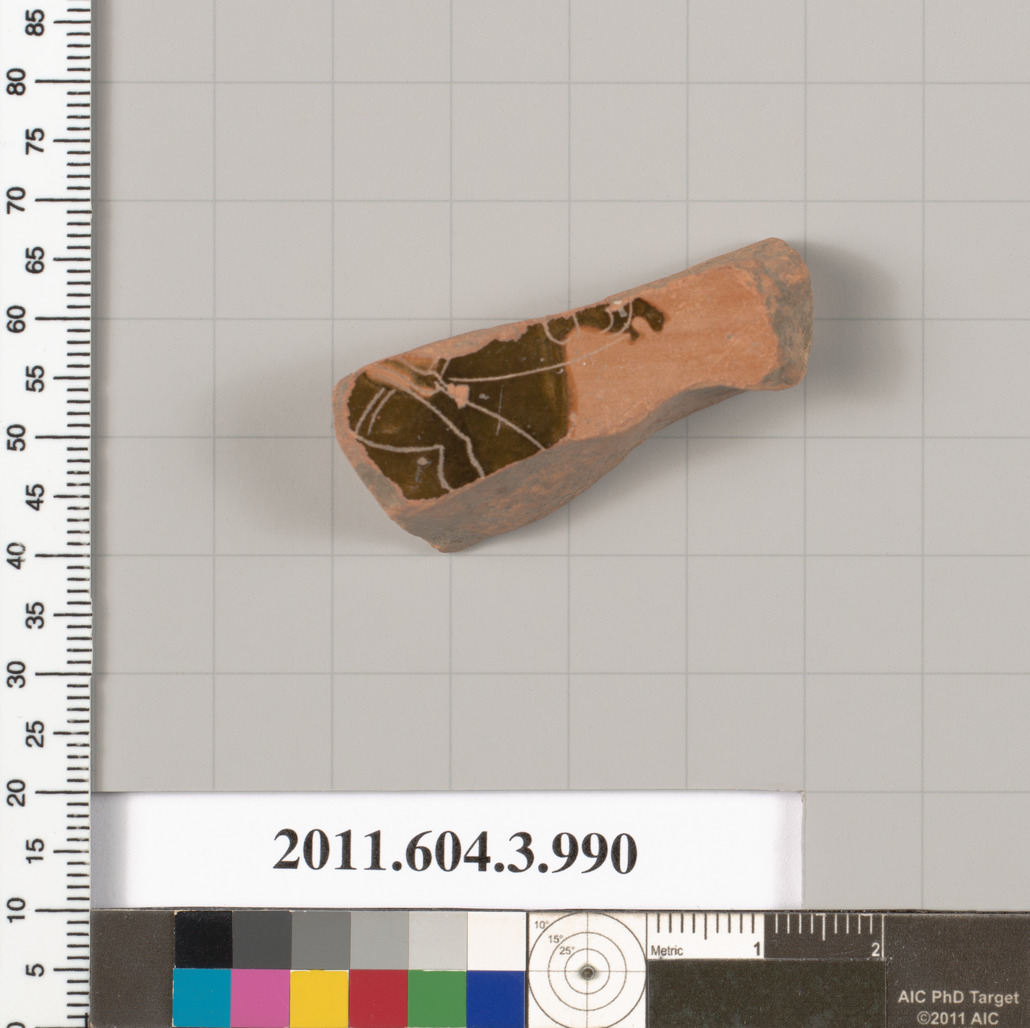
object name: lekanis lid fragment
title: Terracotta fragment of a lekanis lid (covered dish)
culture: greek, attic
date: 575-551 BCE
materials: terracotta